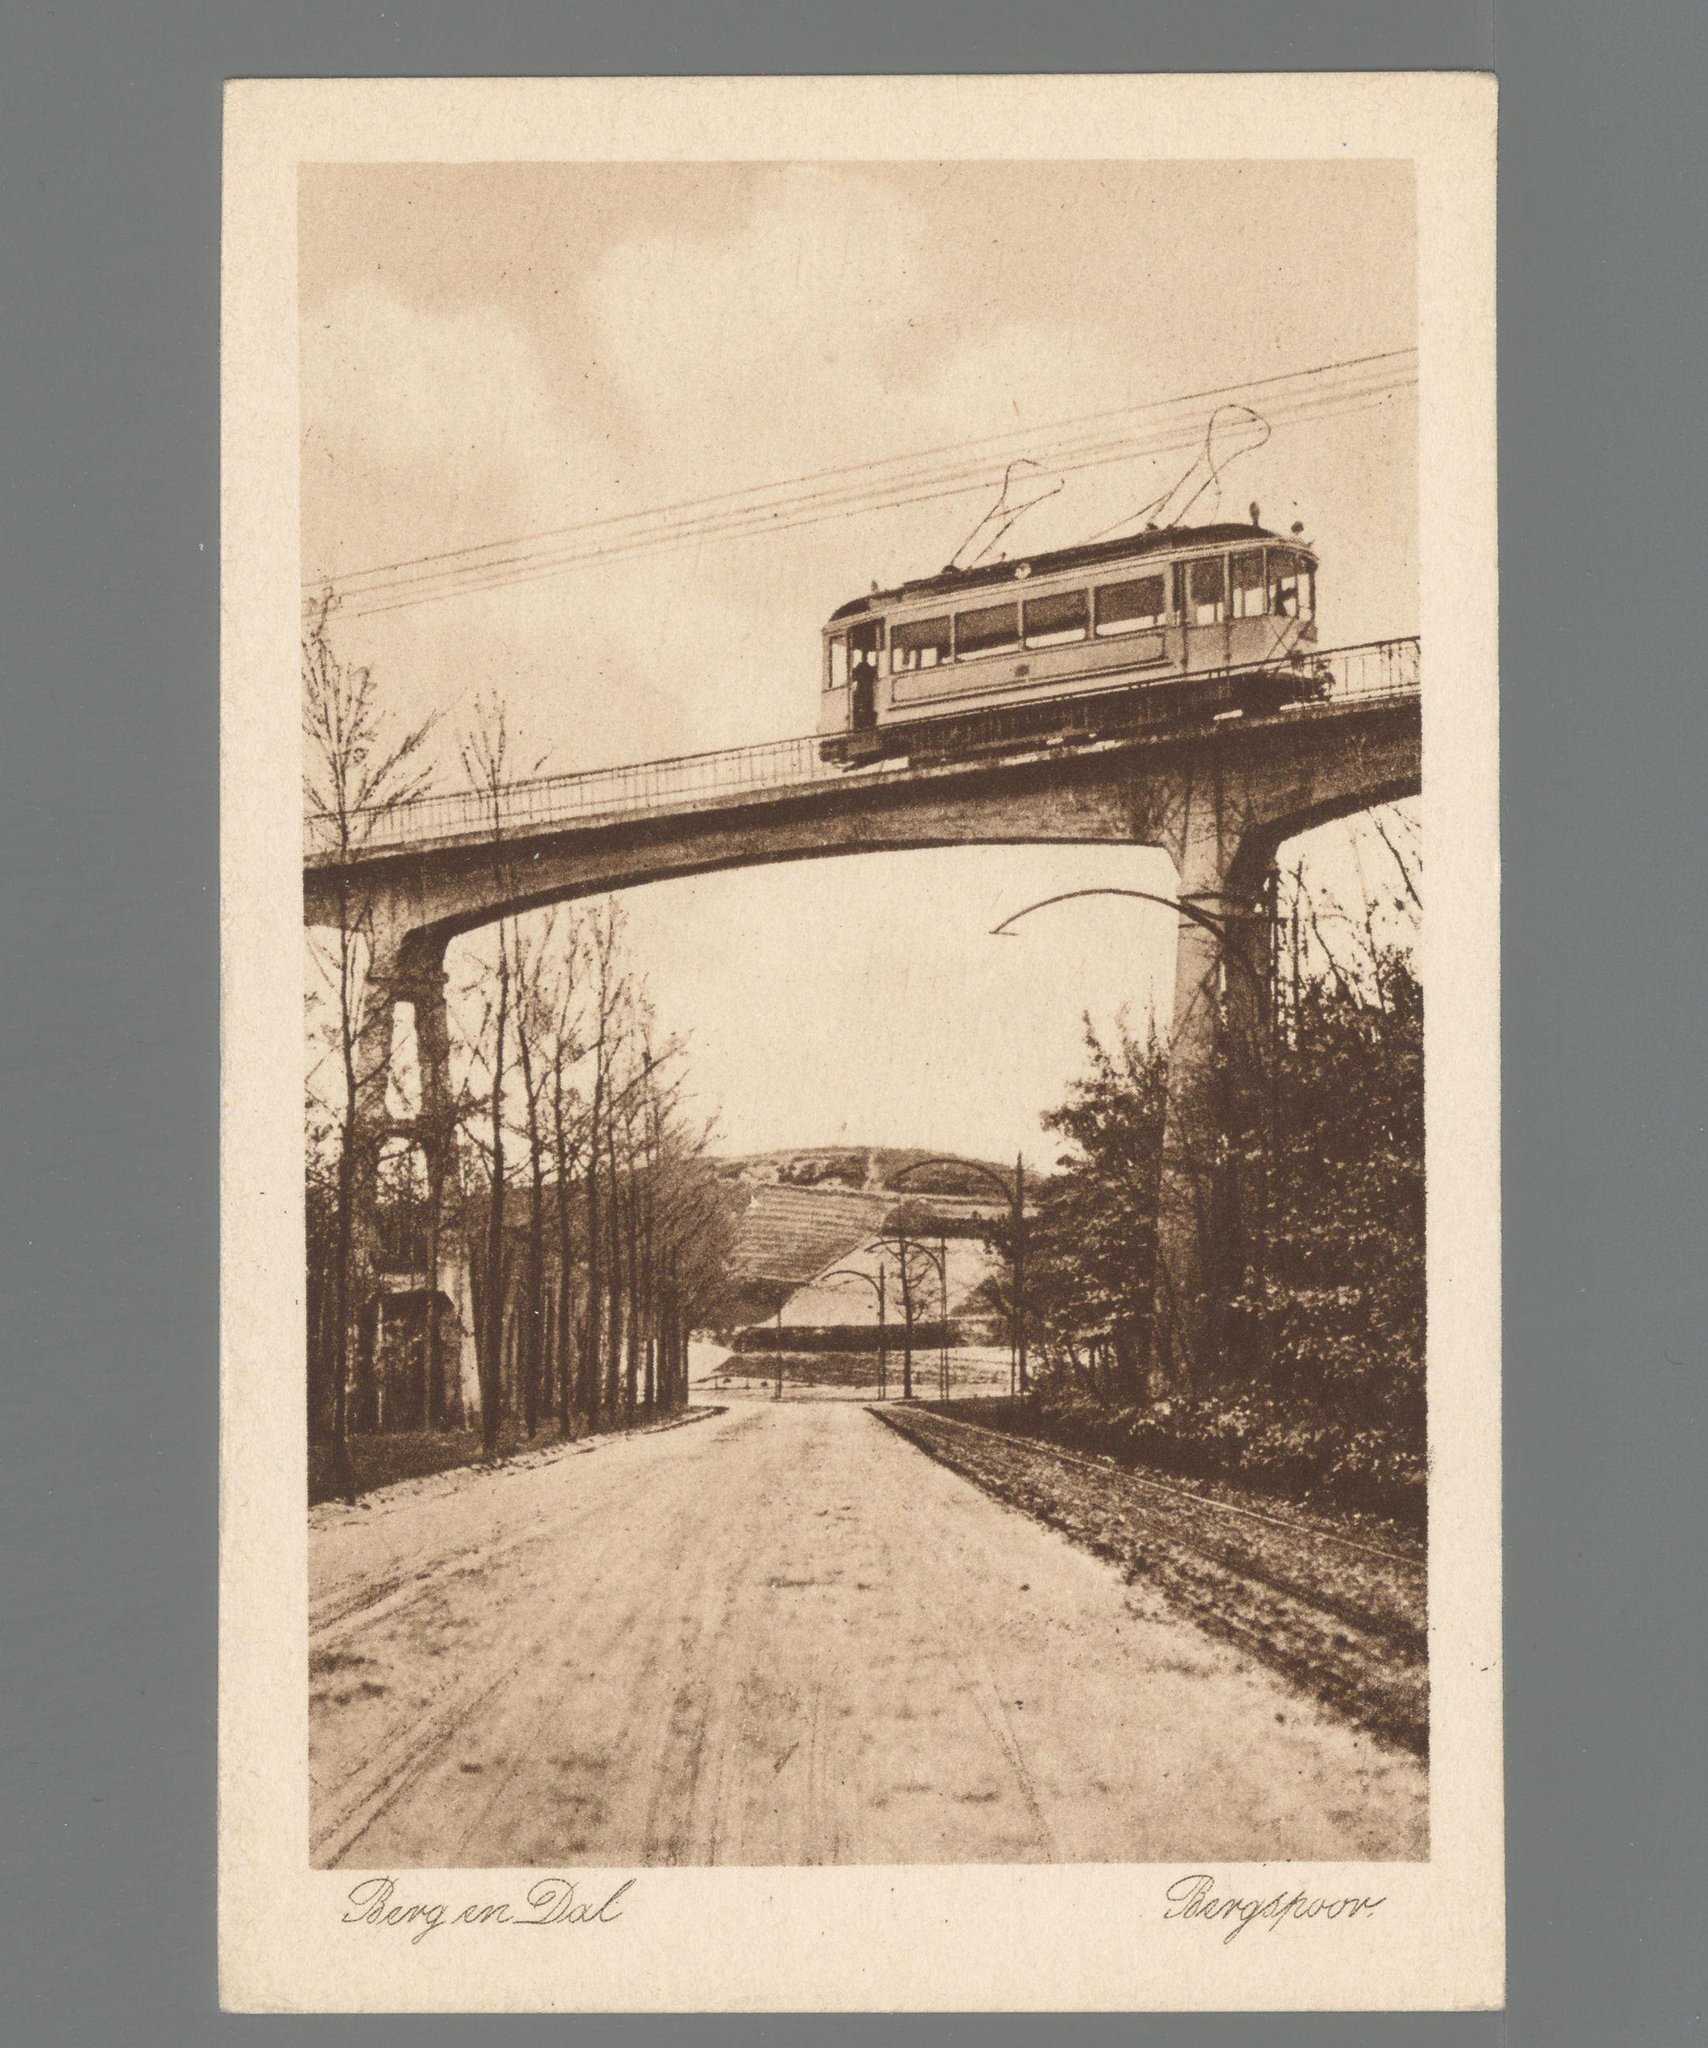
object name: ansichtkaart, prentbriefkaart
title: Berg en Dal. Bergspoor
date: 1913-1930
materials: cardboard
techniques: rotogravure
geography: plasmolen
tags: tram, bridge